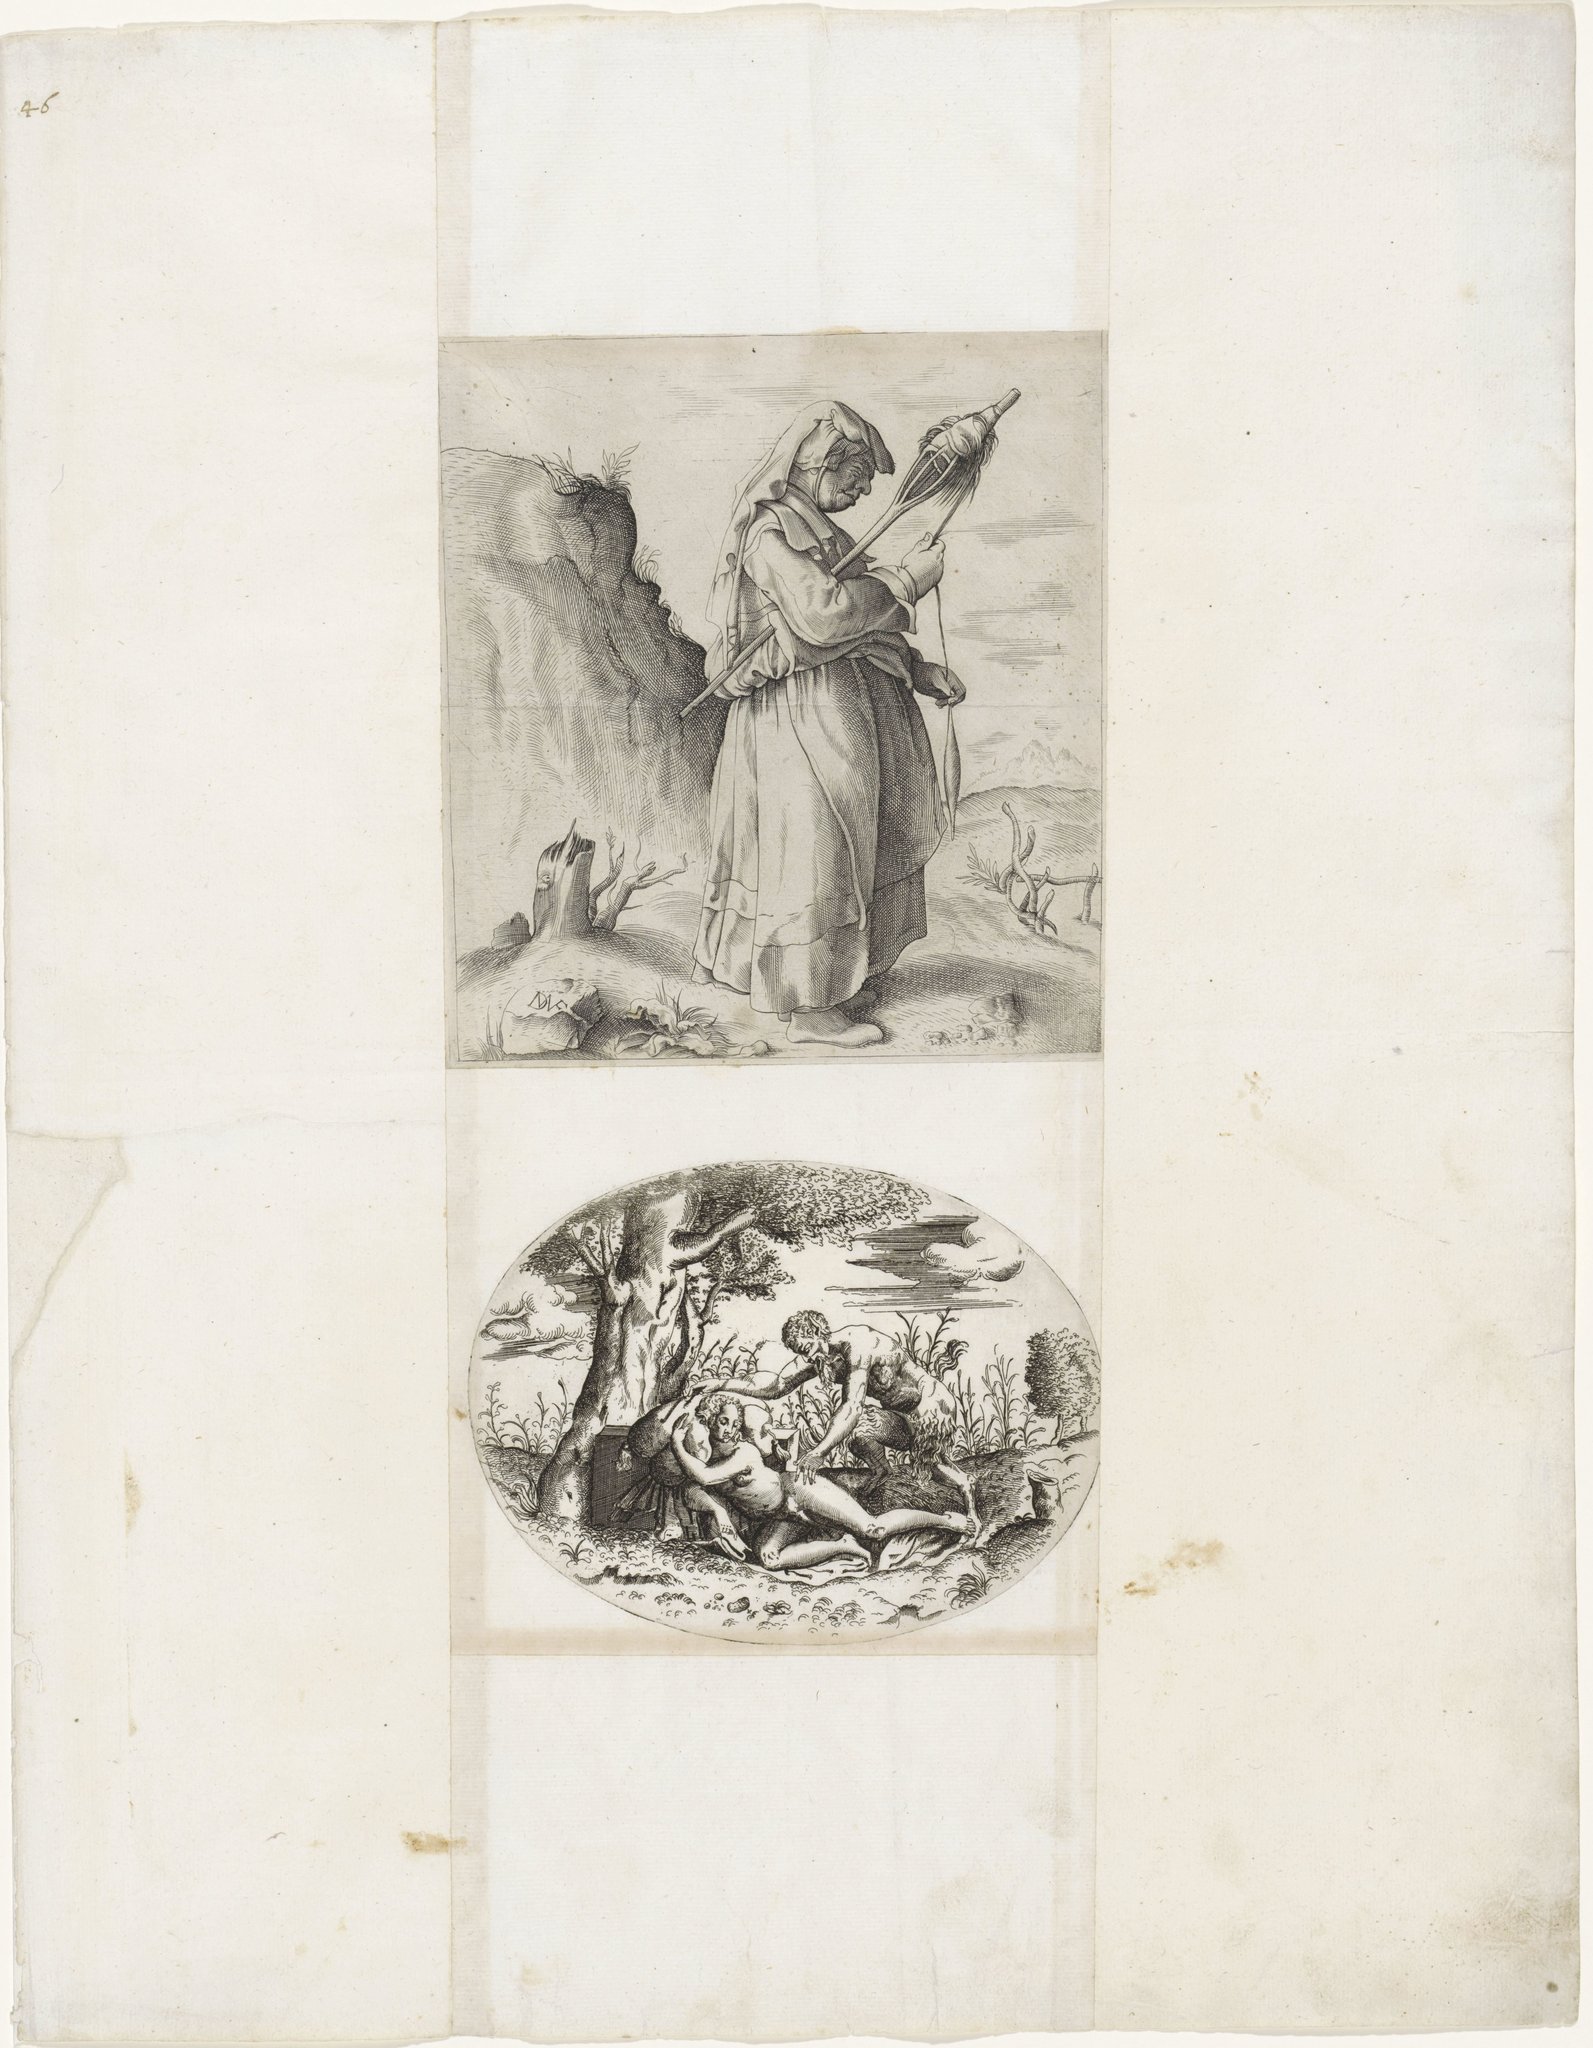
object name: print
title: Spinnende vrouw / Sater en Nimf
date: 1550-1558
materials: paper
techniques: engraving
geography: italy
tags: spindle, satyr(s) pursuing nymph(s)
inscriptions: collector's mark: Lugt 2228, collector's mark: Lugt 2760, watermark, number: ‘46’, watermark, watermark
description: Folio 46 uit het prentalbum van Johann Georg I. Zobel von Giebelstadt (Röttingen 1543-07-20 - Bamberg 1580-09-07), de latere bisschop van Bamberg. Het album is vermoedelijk samengesteld tussen 1568 en 1570 in Venetië. Het album werd in 1999 uit elkaar genomen door een antiquair. De in totaal 124 folio's met prenten uit het "Zobel Album" werden aangekocht door verschillende musea en privéverzamelingen. De grootste groep (68 folio's) bevindt zich in de collectie van het Rijksmuseum. Prent boven: naar een prent door Enea Vico (RP-P-OB-38.311), naar een tekening van Parmigianino (Chatsworth, Devonshire Collection, inv. nr.: 773). Prent beneden: hoogstwaarschijnlijk naar een verloren gegaan ontwerp door Parmigianino (Zelen 2013).